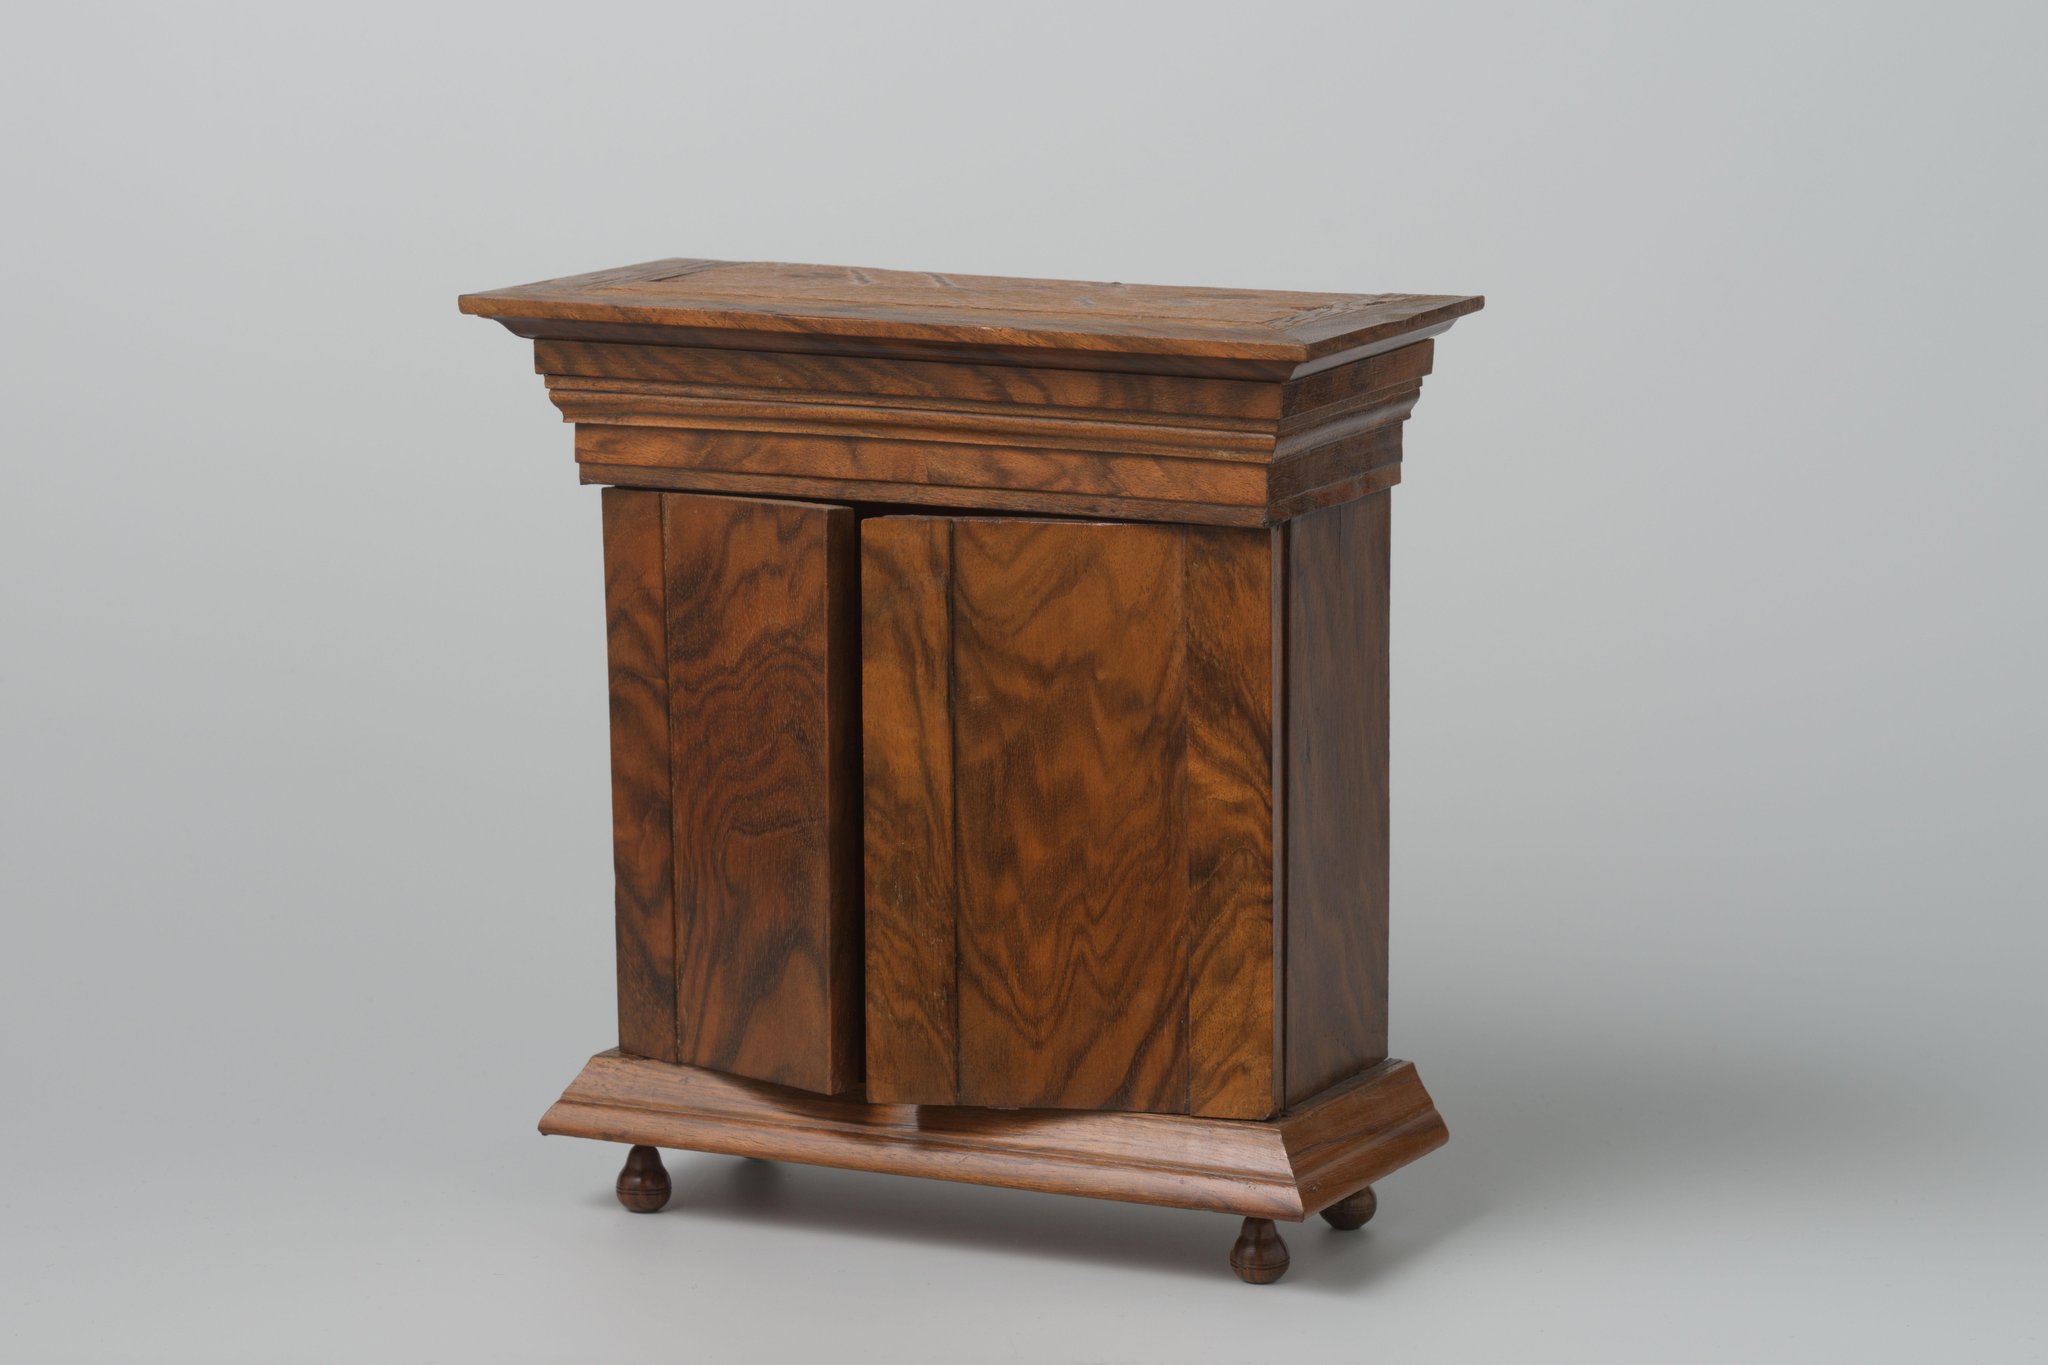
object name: case furniture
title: Kast met twee deuren, belijmd met notenhout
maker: Anonymous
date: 1676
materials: metal, wood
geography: amsterdam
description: Kast met twee deuren, vervaardigd van eikenhout belijmd met fineer en massieve profiellijsten van notenhout. De kast heeft een overstekende kap met geprofileerde lijst, twee deuren met vlakke pilasters (middelste pilaster zit vast aan rechter deur) draaiend op speunen en een geprofileerde, ver naar buiten stekende bodem, rustend op vier bolpoten van notenhout. In de kast zijn twee planken aangebracht, de onderste over de volle diepte van de kast met één lade (uit één stuk gemaakt) de bovenste plank iets minder diep.